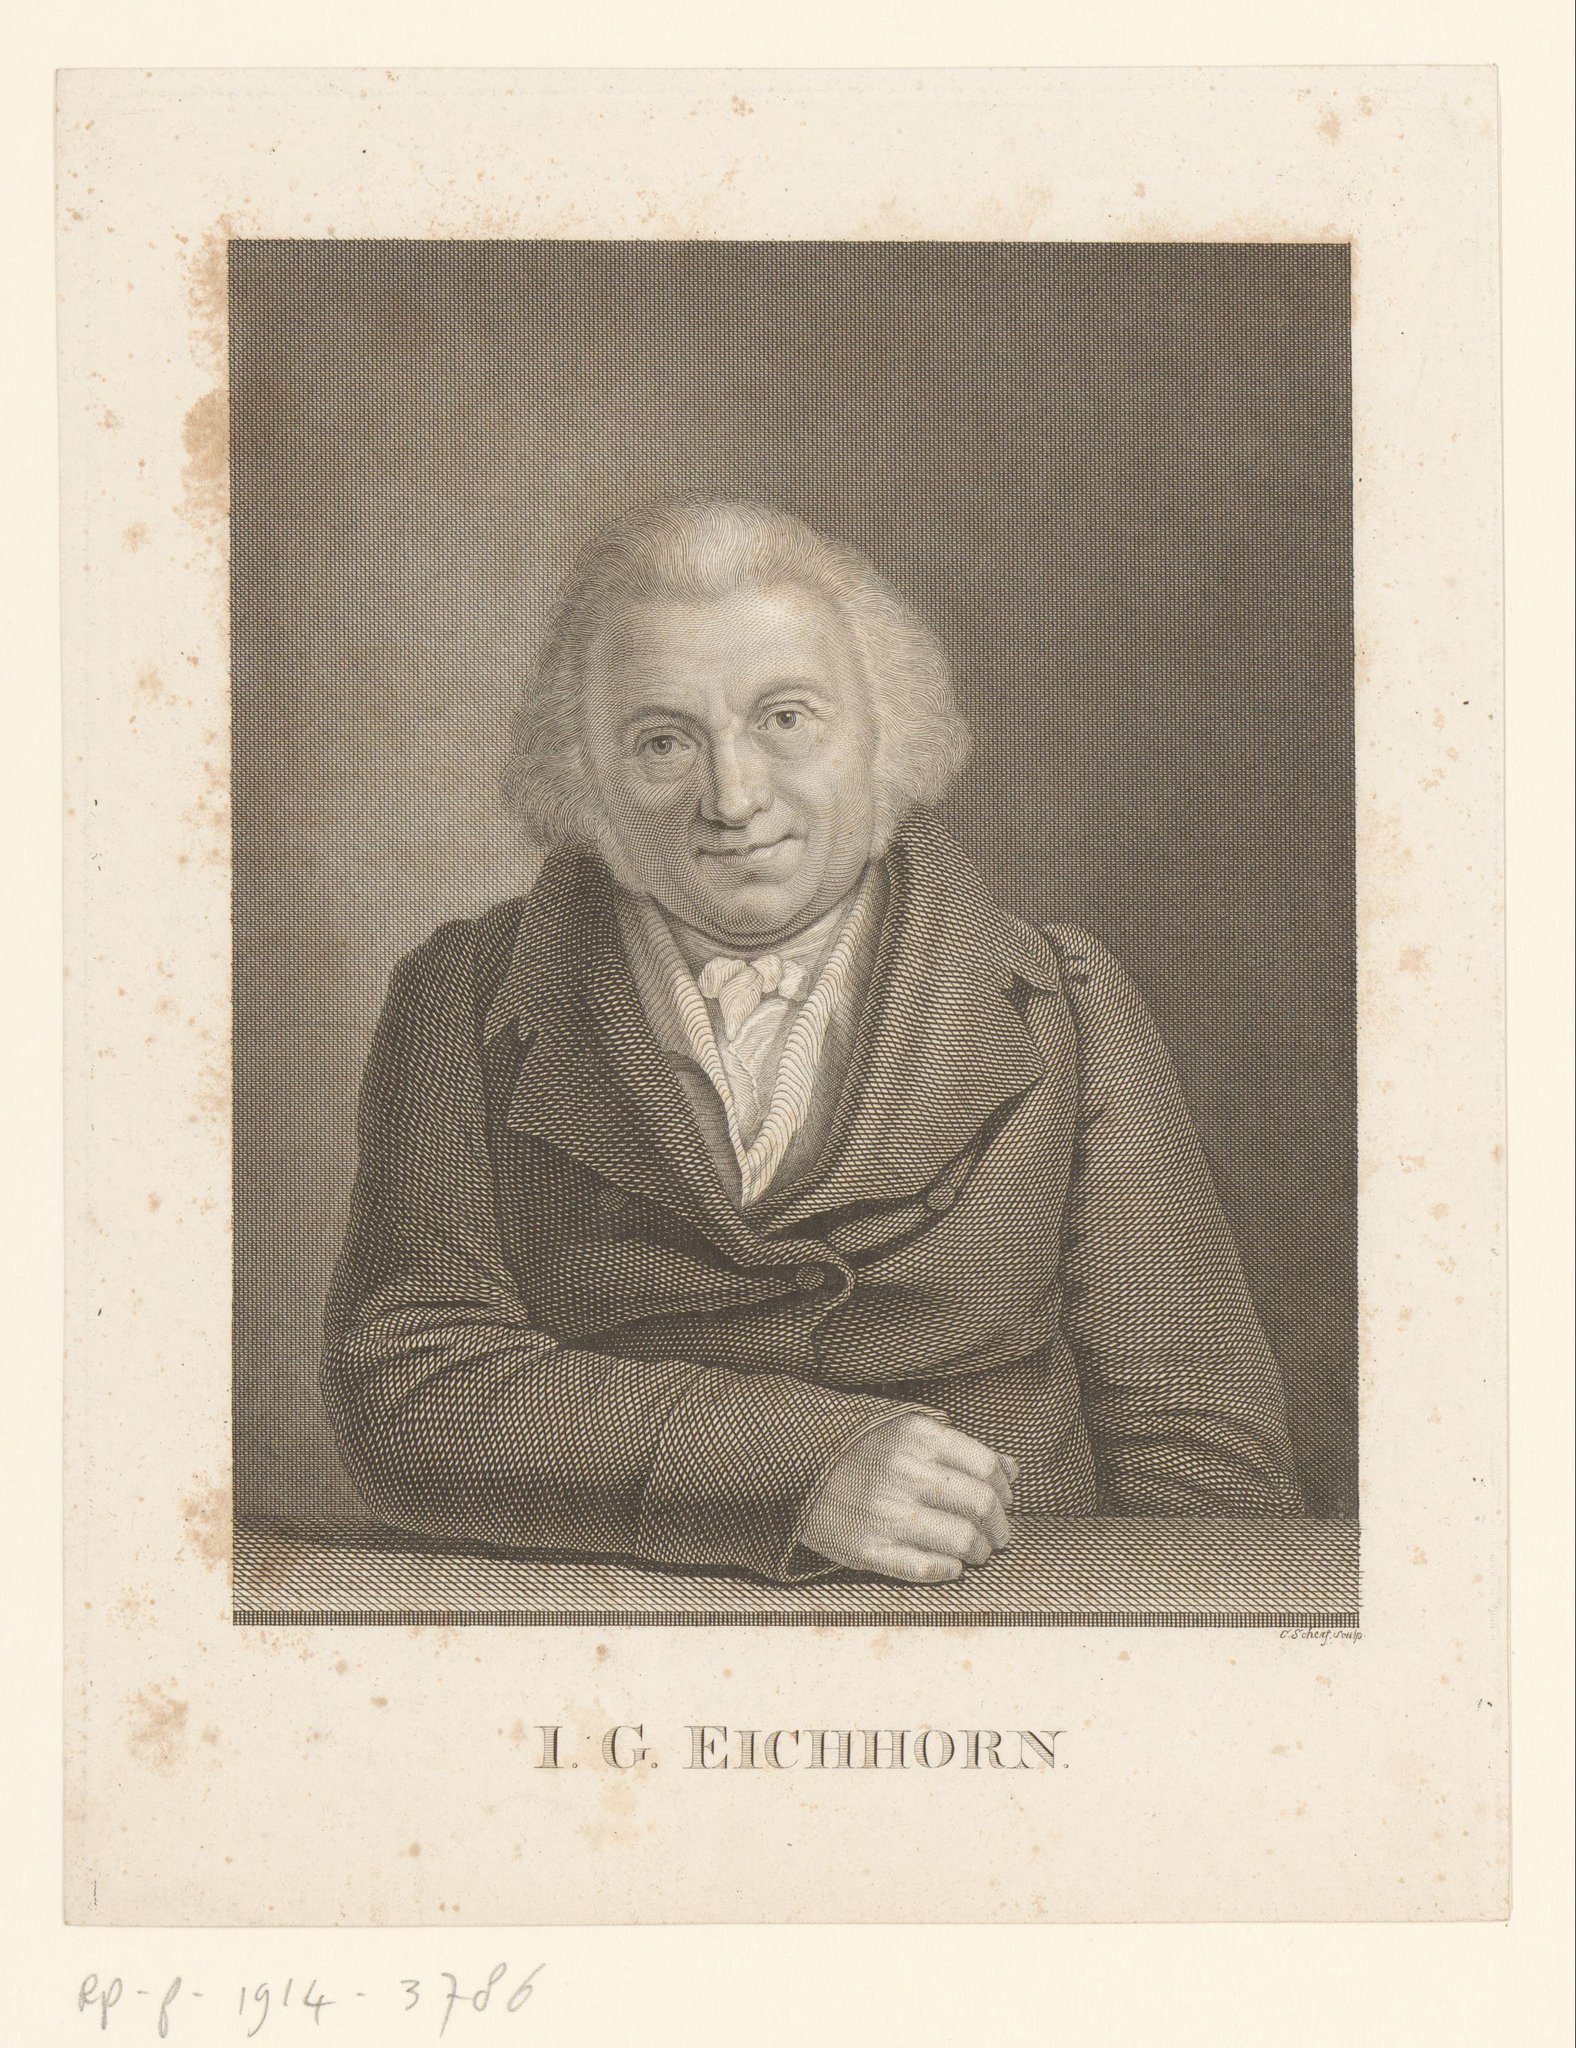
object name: print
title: Portret van Johann Gottfried Eichhorn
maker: christian gottlob scherf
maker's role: print maker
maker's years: 1793-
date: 1803-1849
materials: paper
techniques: engraving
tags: historical persons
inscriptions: collector's mark: Lugt 2228